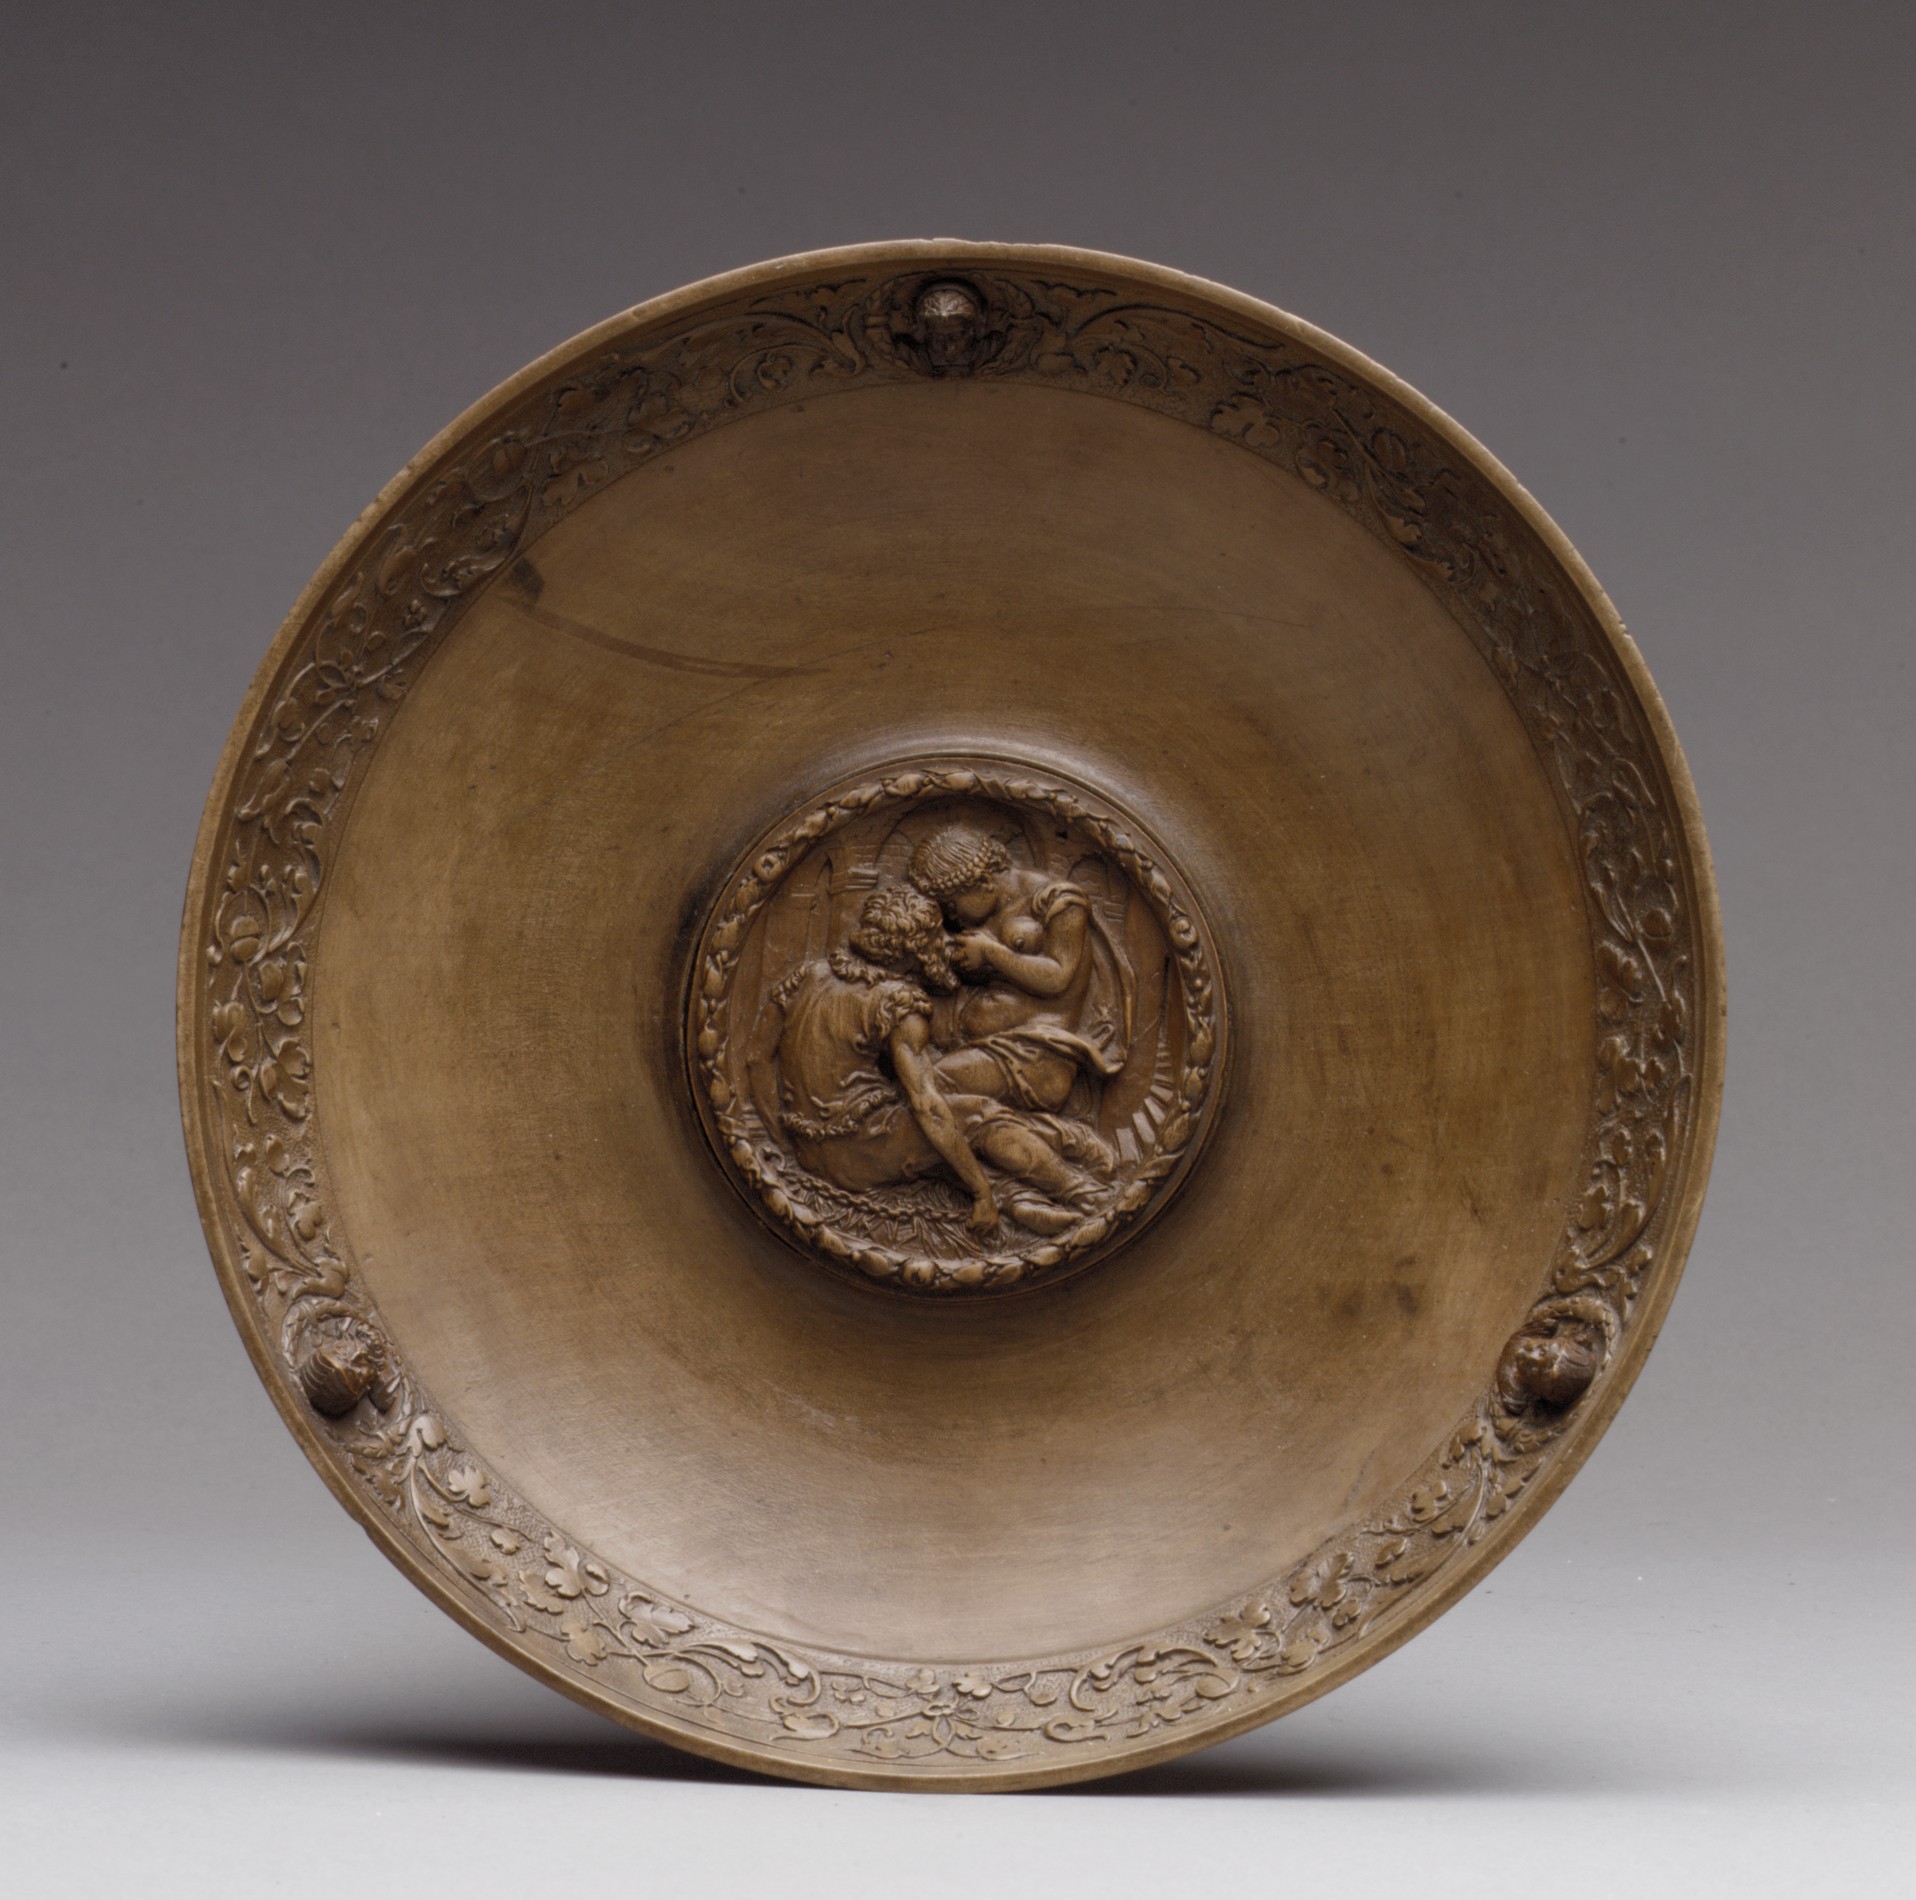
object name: bowl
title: Goldsmith's model for a bowl with a representation of Roman Charity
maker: sebald beham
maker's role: artist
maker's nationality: german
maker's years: 1500-1550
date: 1540-1550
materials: wood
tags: men,women,nursing